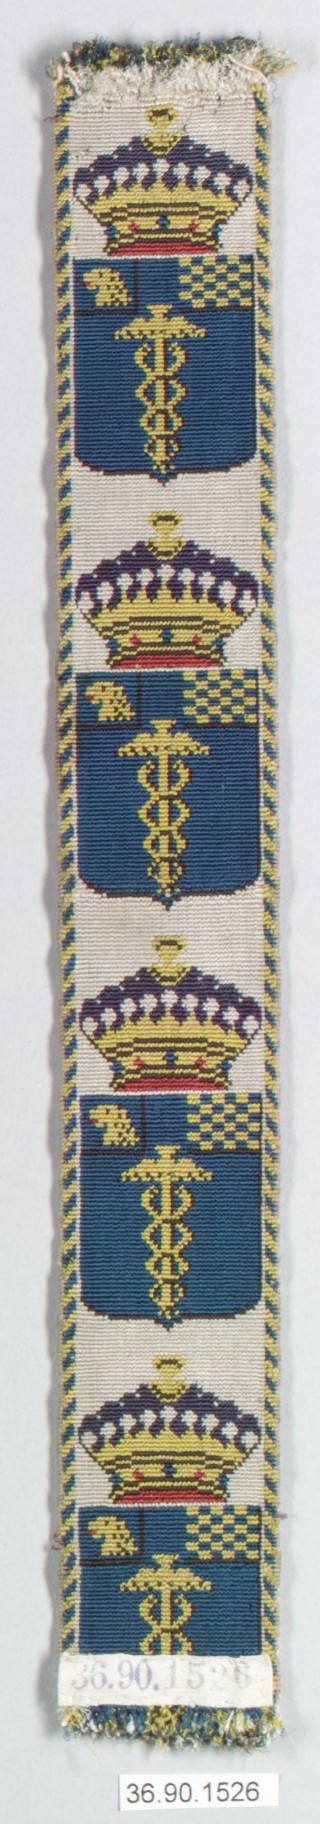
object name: galloon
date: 1701-1900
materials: silk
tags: coat of arms